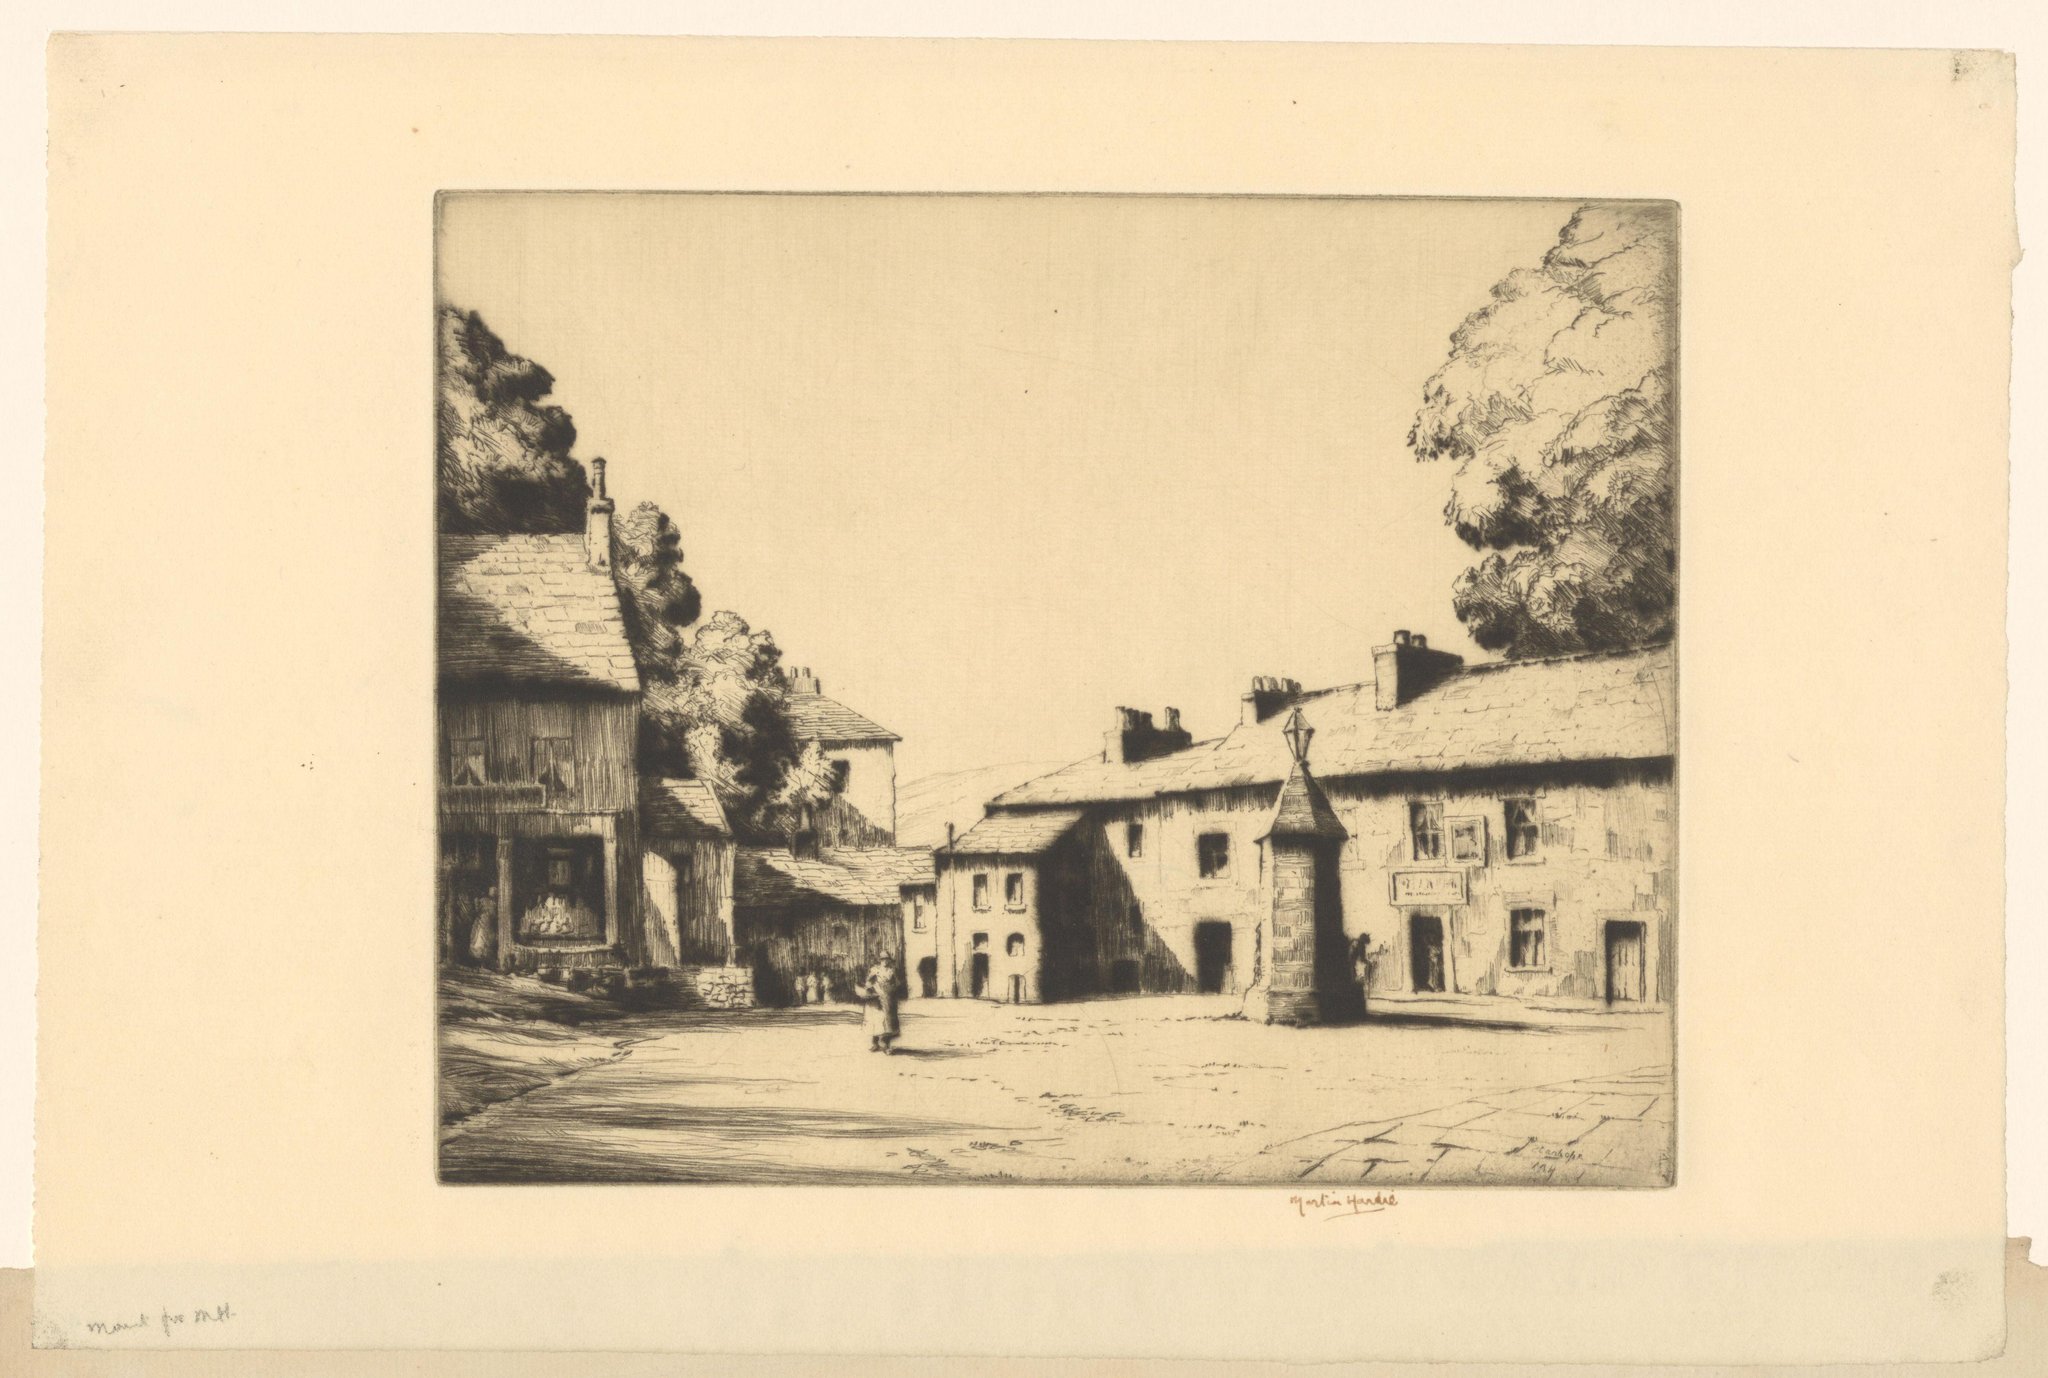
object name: print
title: Stanhope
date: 1919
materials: paper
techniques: drypoint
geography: stanhope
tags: village square, place (+ city(-scape) with figures, staffage)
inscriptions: collector's mark: Lugt 2228, collector's mark: Lugt 2760, annotation: ‘Martin Hardie’